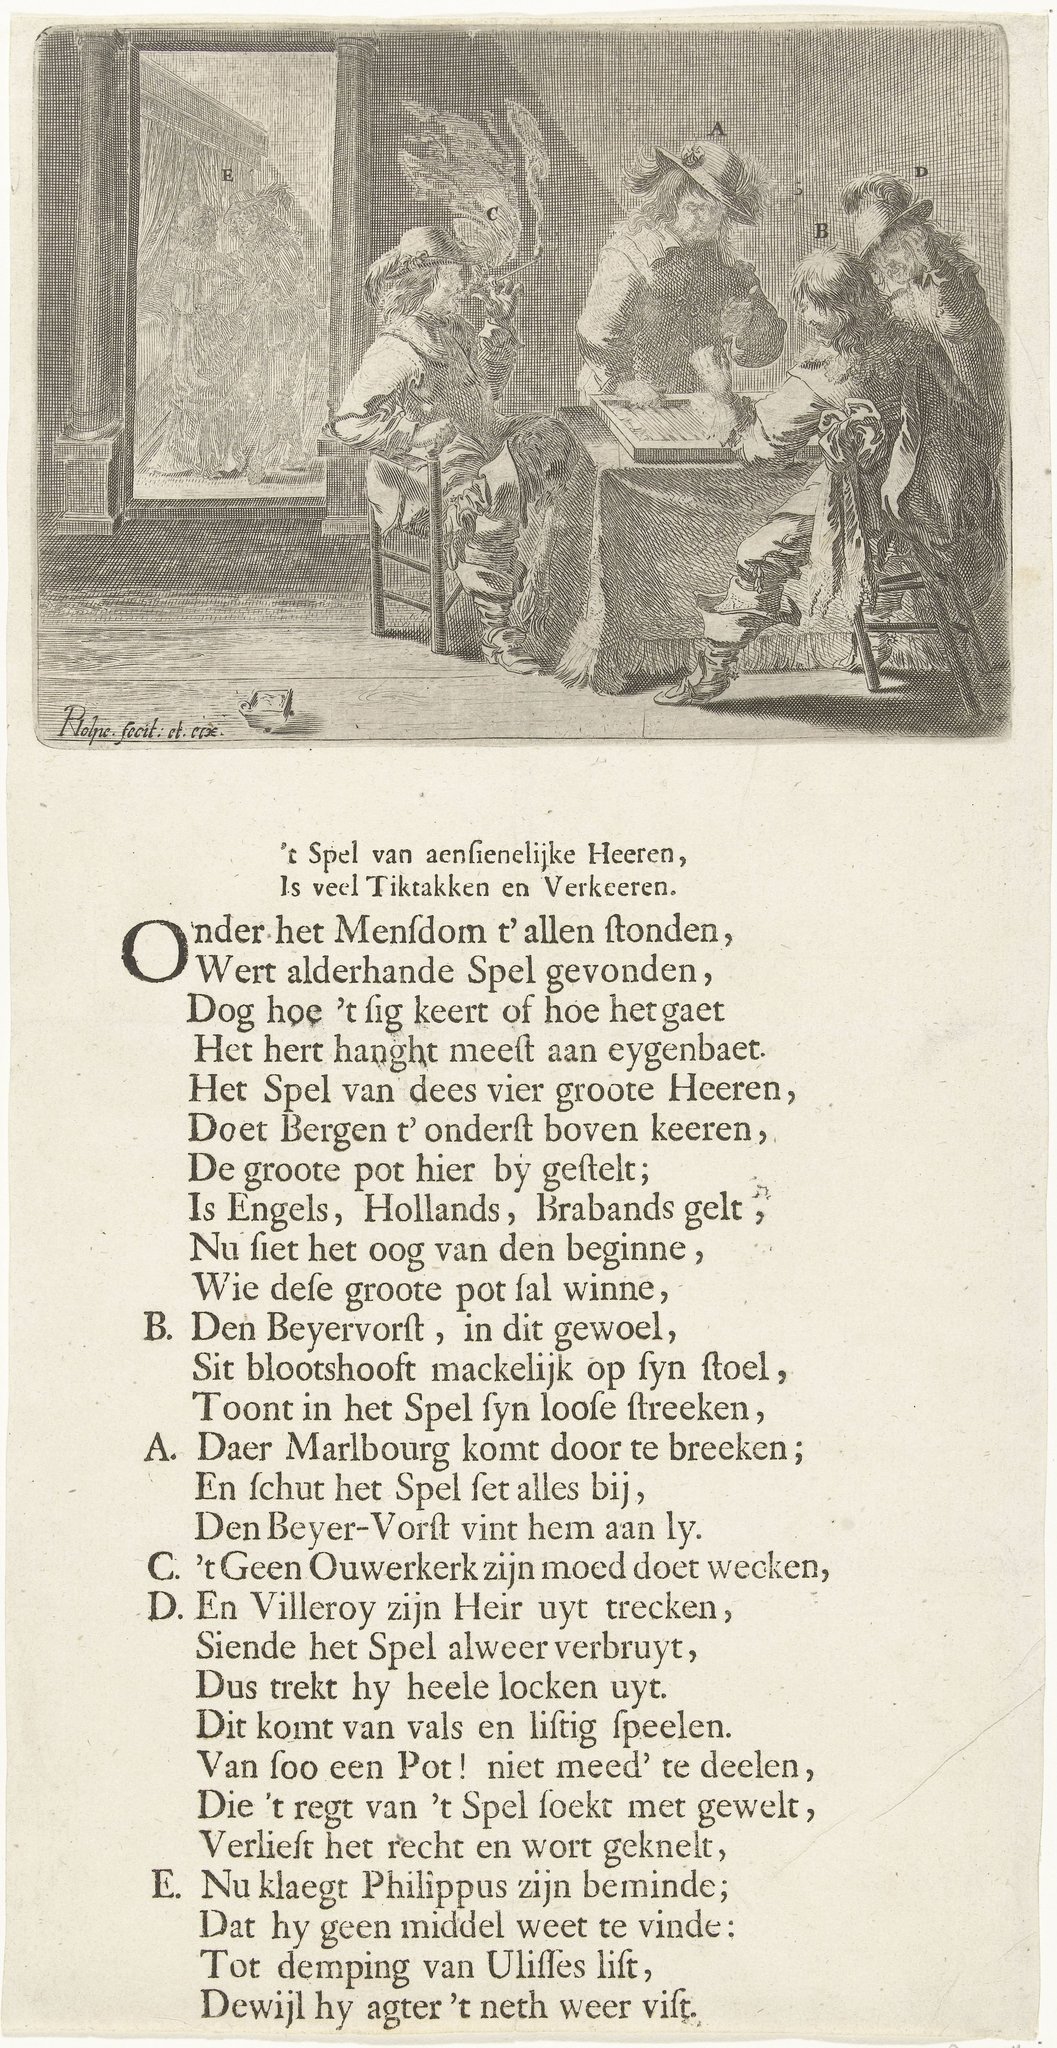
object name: cartoon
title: Triktrak spel om Bergen, 1709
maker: pieter nolpe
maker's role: draughtsman, print maker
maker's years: 1613-1653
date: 1623-1653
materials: paper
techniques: engraving, etching, letterpress printing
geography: northern netherlands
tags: lyon, paris, françois de neufville (hertog van villeroy), maximiliaan ii emanuel (keurvorst van beieren), john churchill (1e hertog van marlborough), the hague, backgammon, tric-trac, political caricatures and satires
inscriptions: collector's mark: Lugt 2228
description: Interieur waarin vier heren: de hertog van Marlborough, de heer van Ouwerkerk, de hertog van Villeroy en de keurvorst van Beieren, triktrak spelen om de stad Mons (Bergen), 1709. Op de achtergrond koning Filips V met een vrouw in de slaapkamer. Op het blad onder de plaat een vers in één kolom in het Nederlands. De prent verwijst naar het beleg en de verovering van Mons door de Geallieerden op de Fransen in 1709.